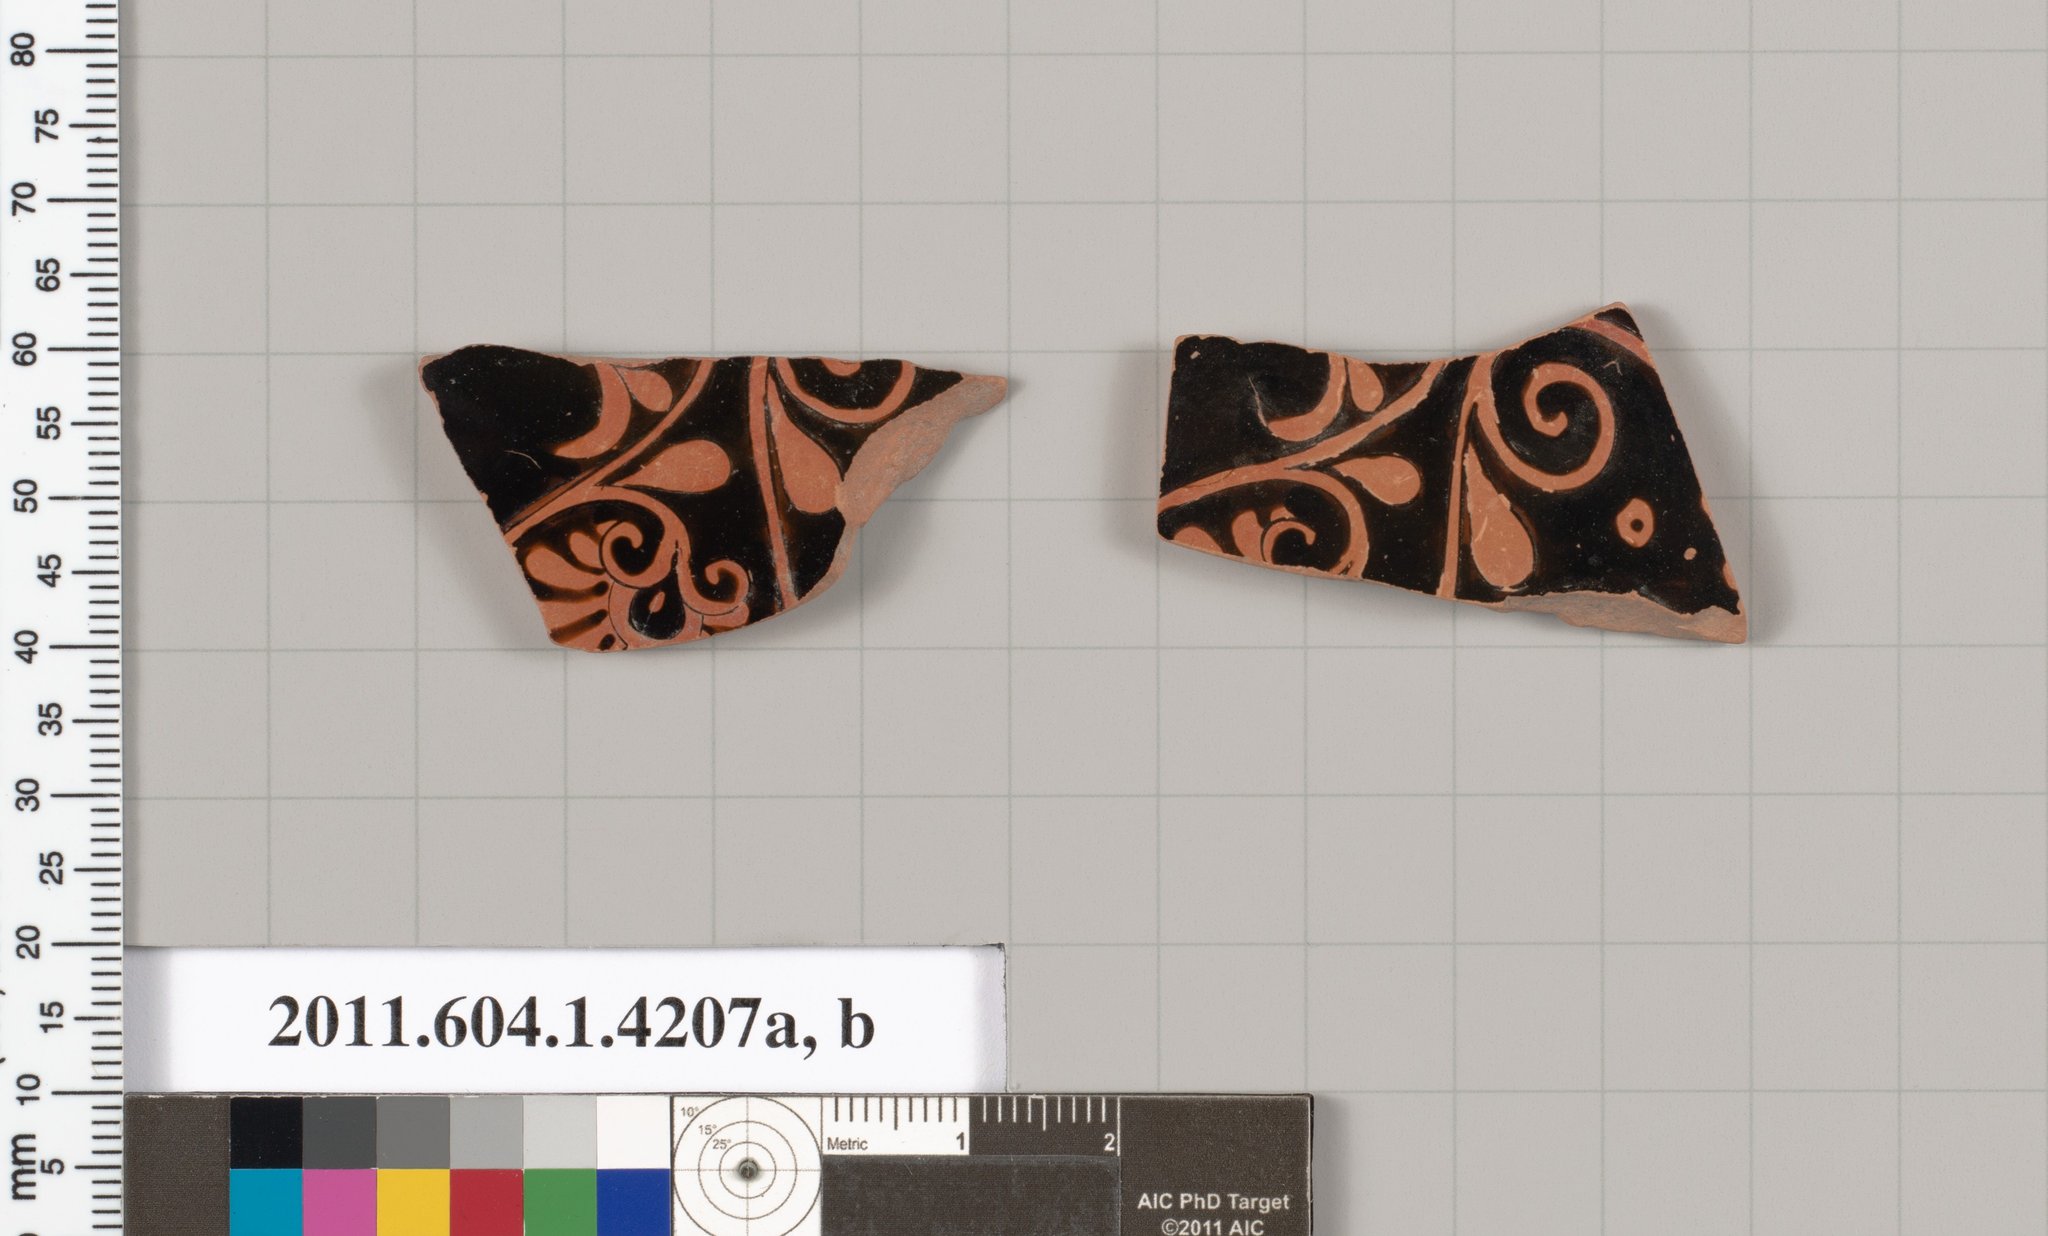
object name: kylix fragment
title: Terracotta fragments of kylikes (drinking cups)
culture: greek, attic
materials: terracotta